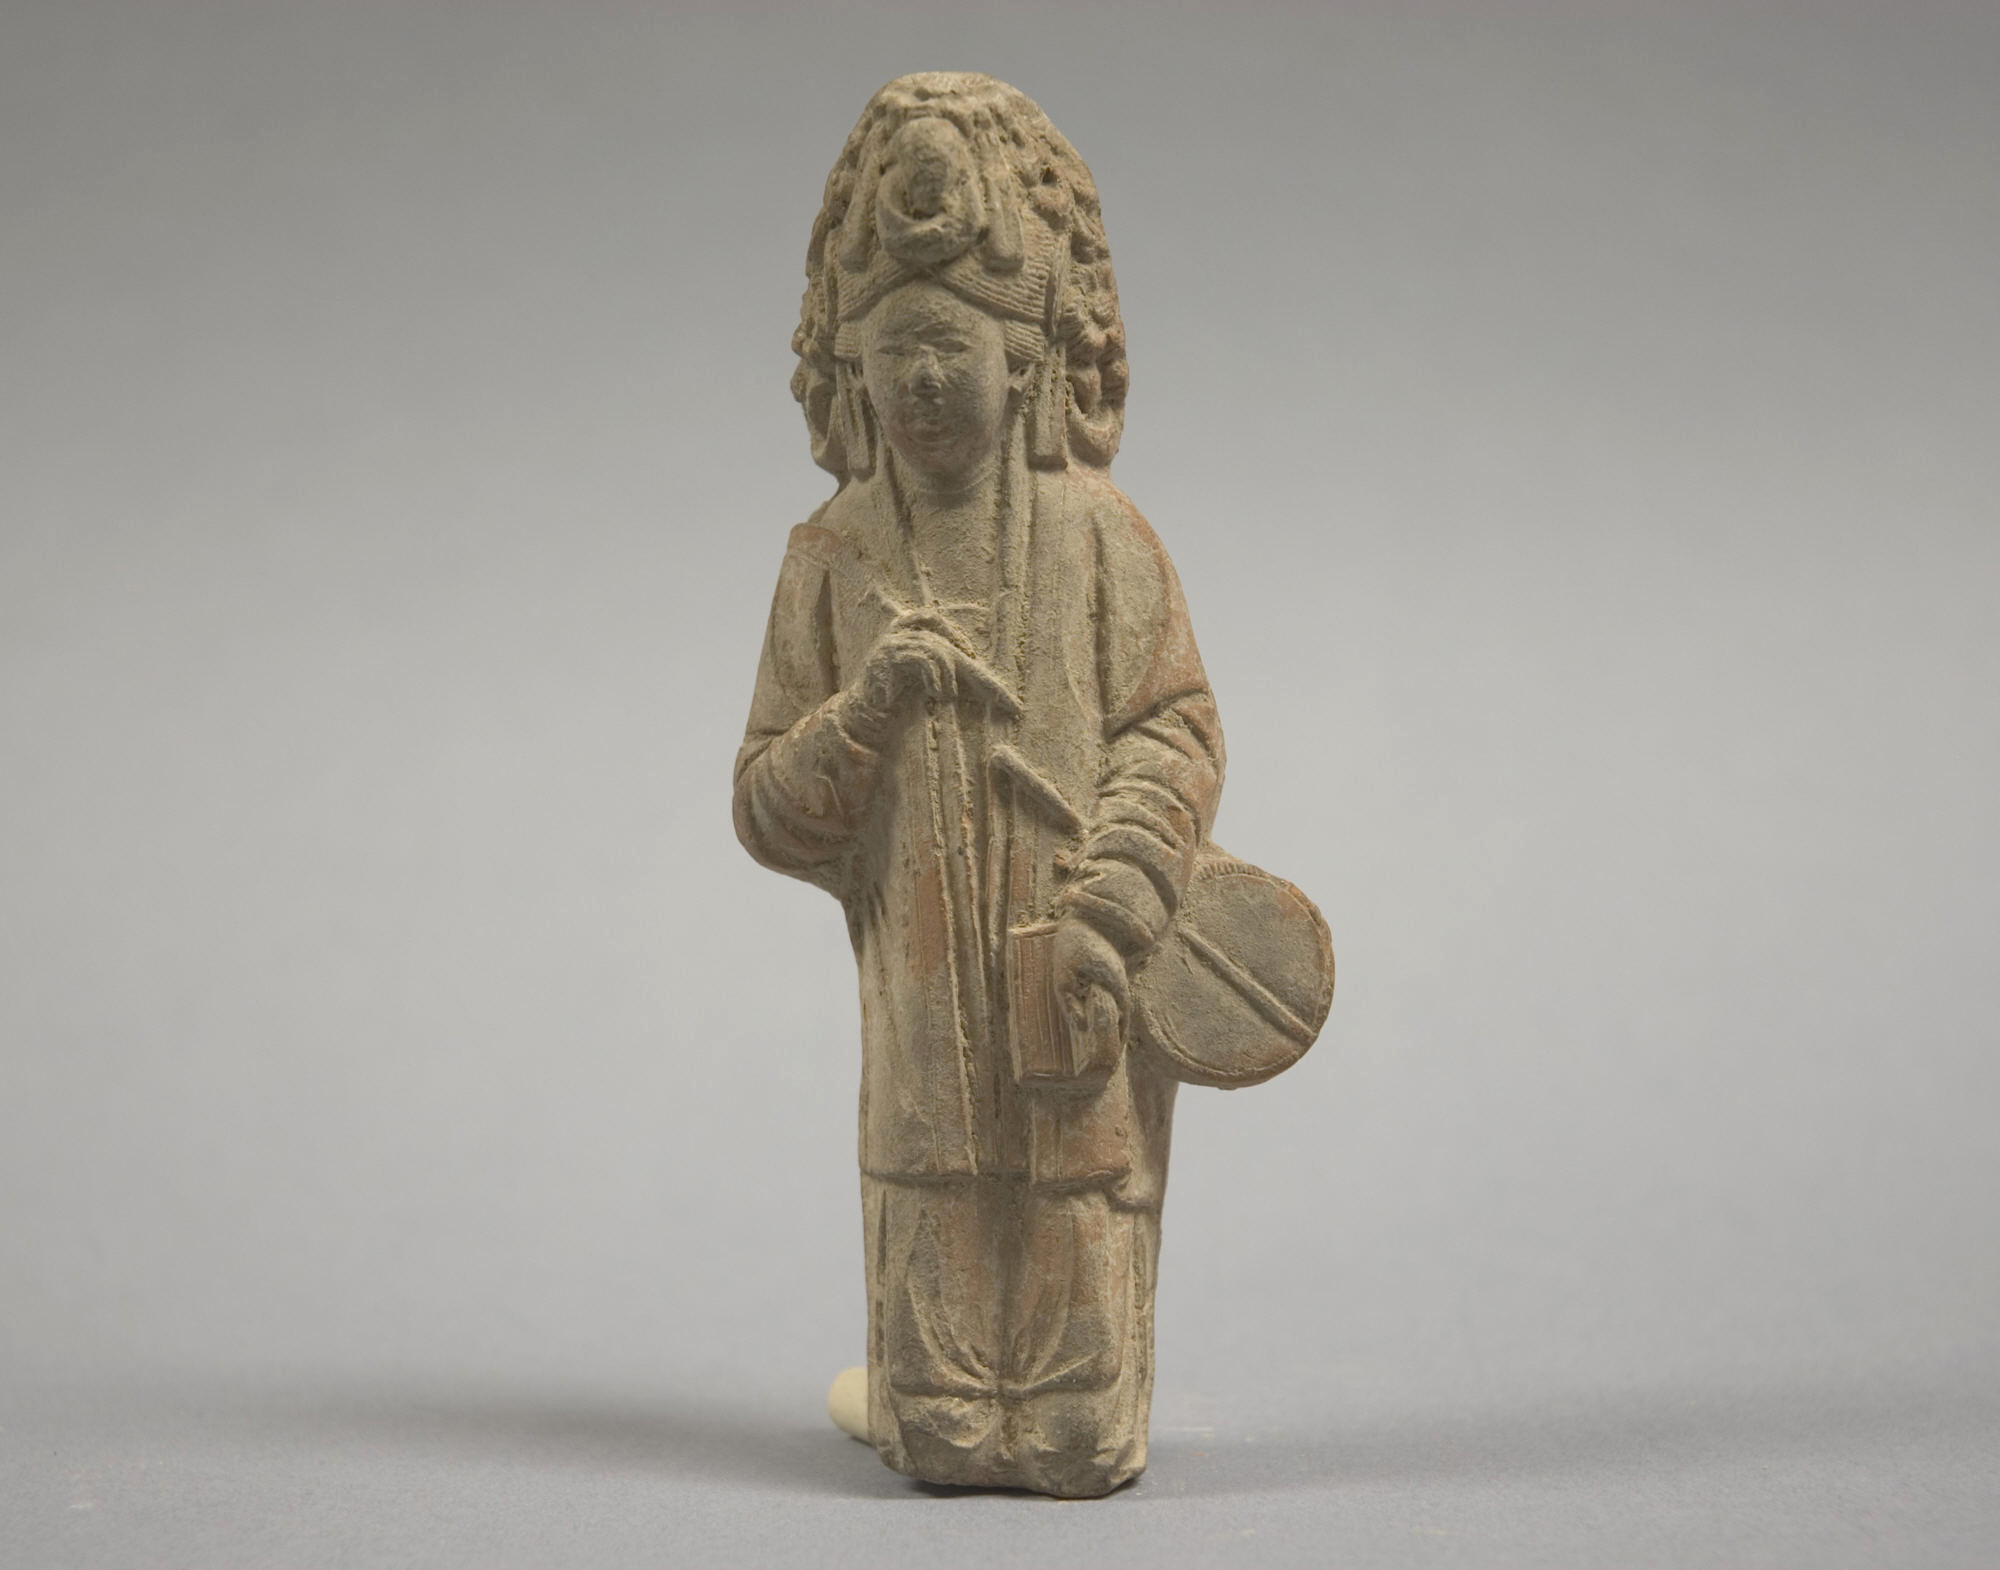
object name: figure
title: Figure of Goddess of Music and Poetry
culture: chinese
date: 960-1279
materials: pottery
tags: goddess